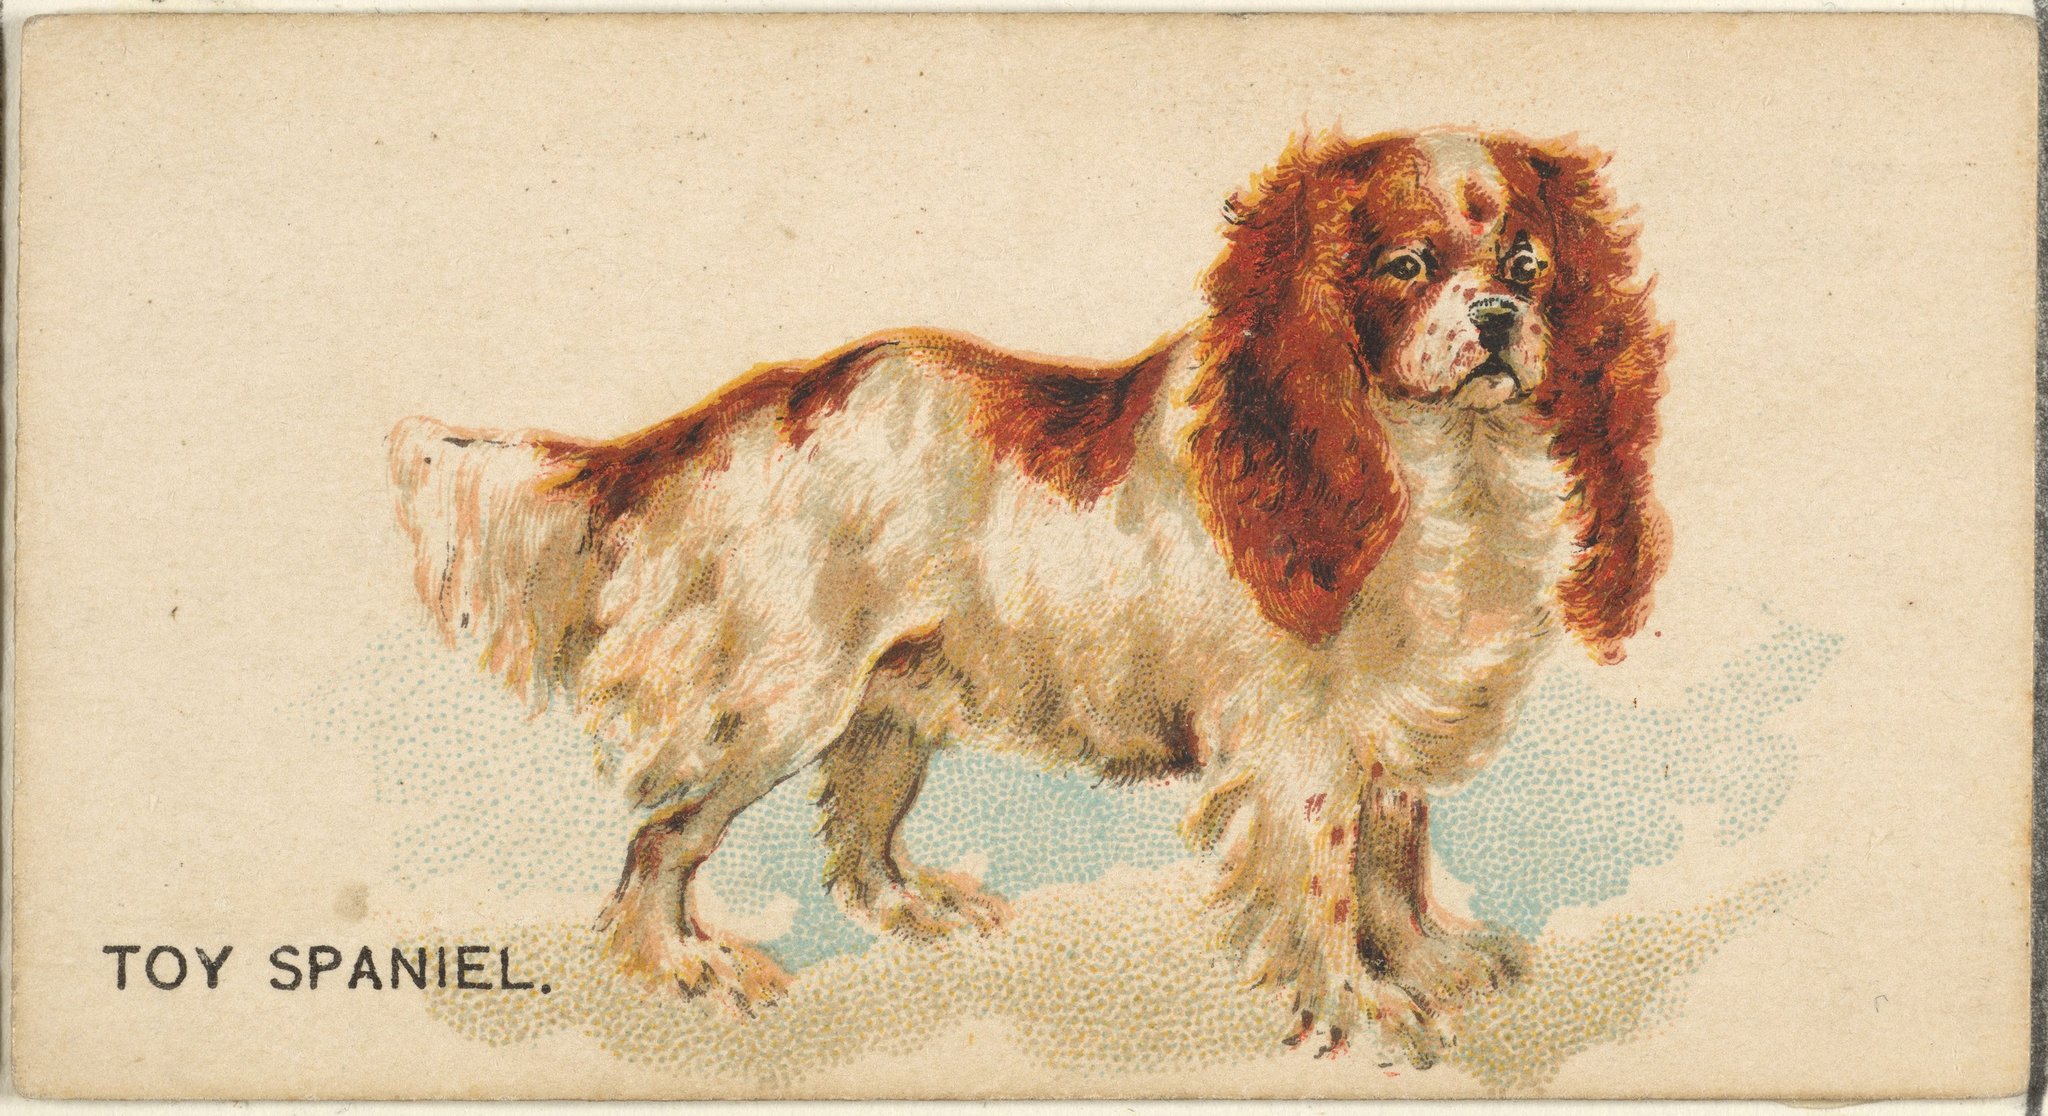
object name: print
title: Toy Spaniel, from the Dogs of the World series for Old Judge Cigarettes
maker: goodwin & company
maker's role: publisher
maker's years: 1850-1950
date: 1890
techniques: color lithograph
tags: dogs